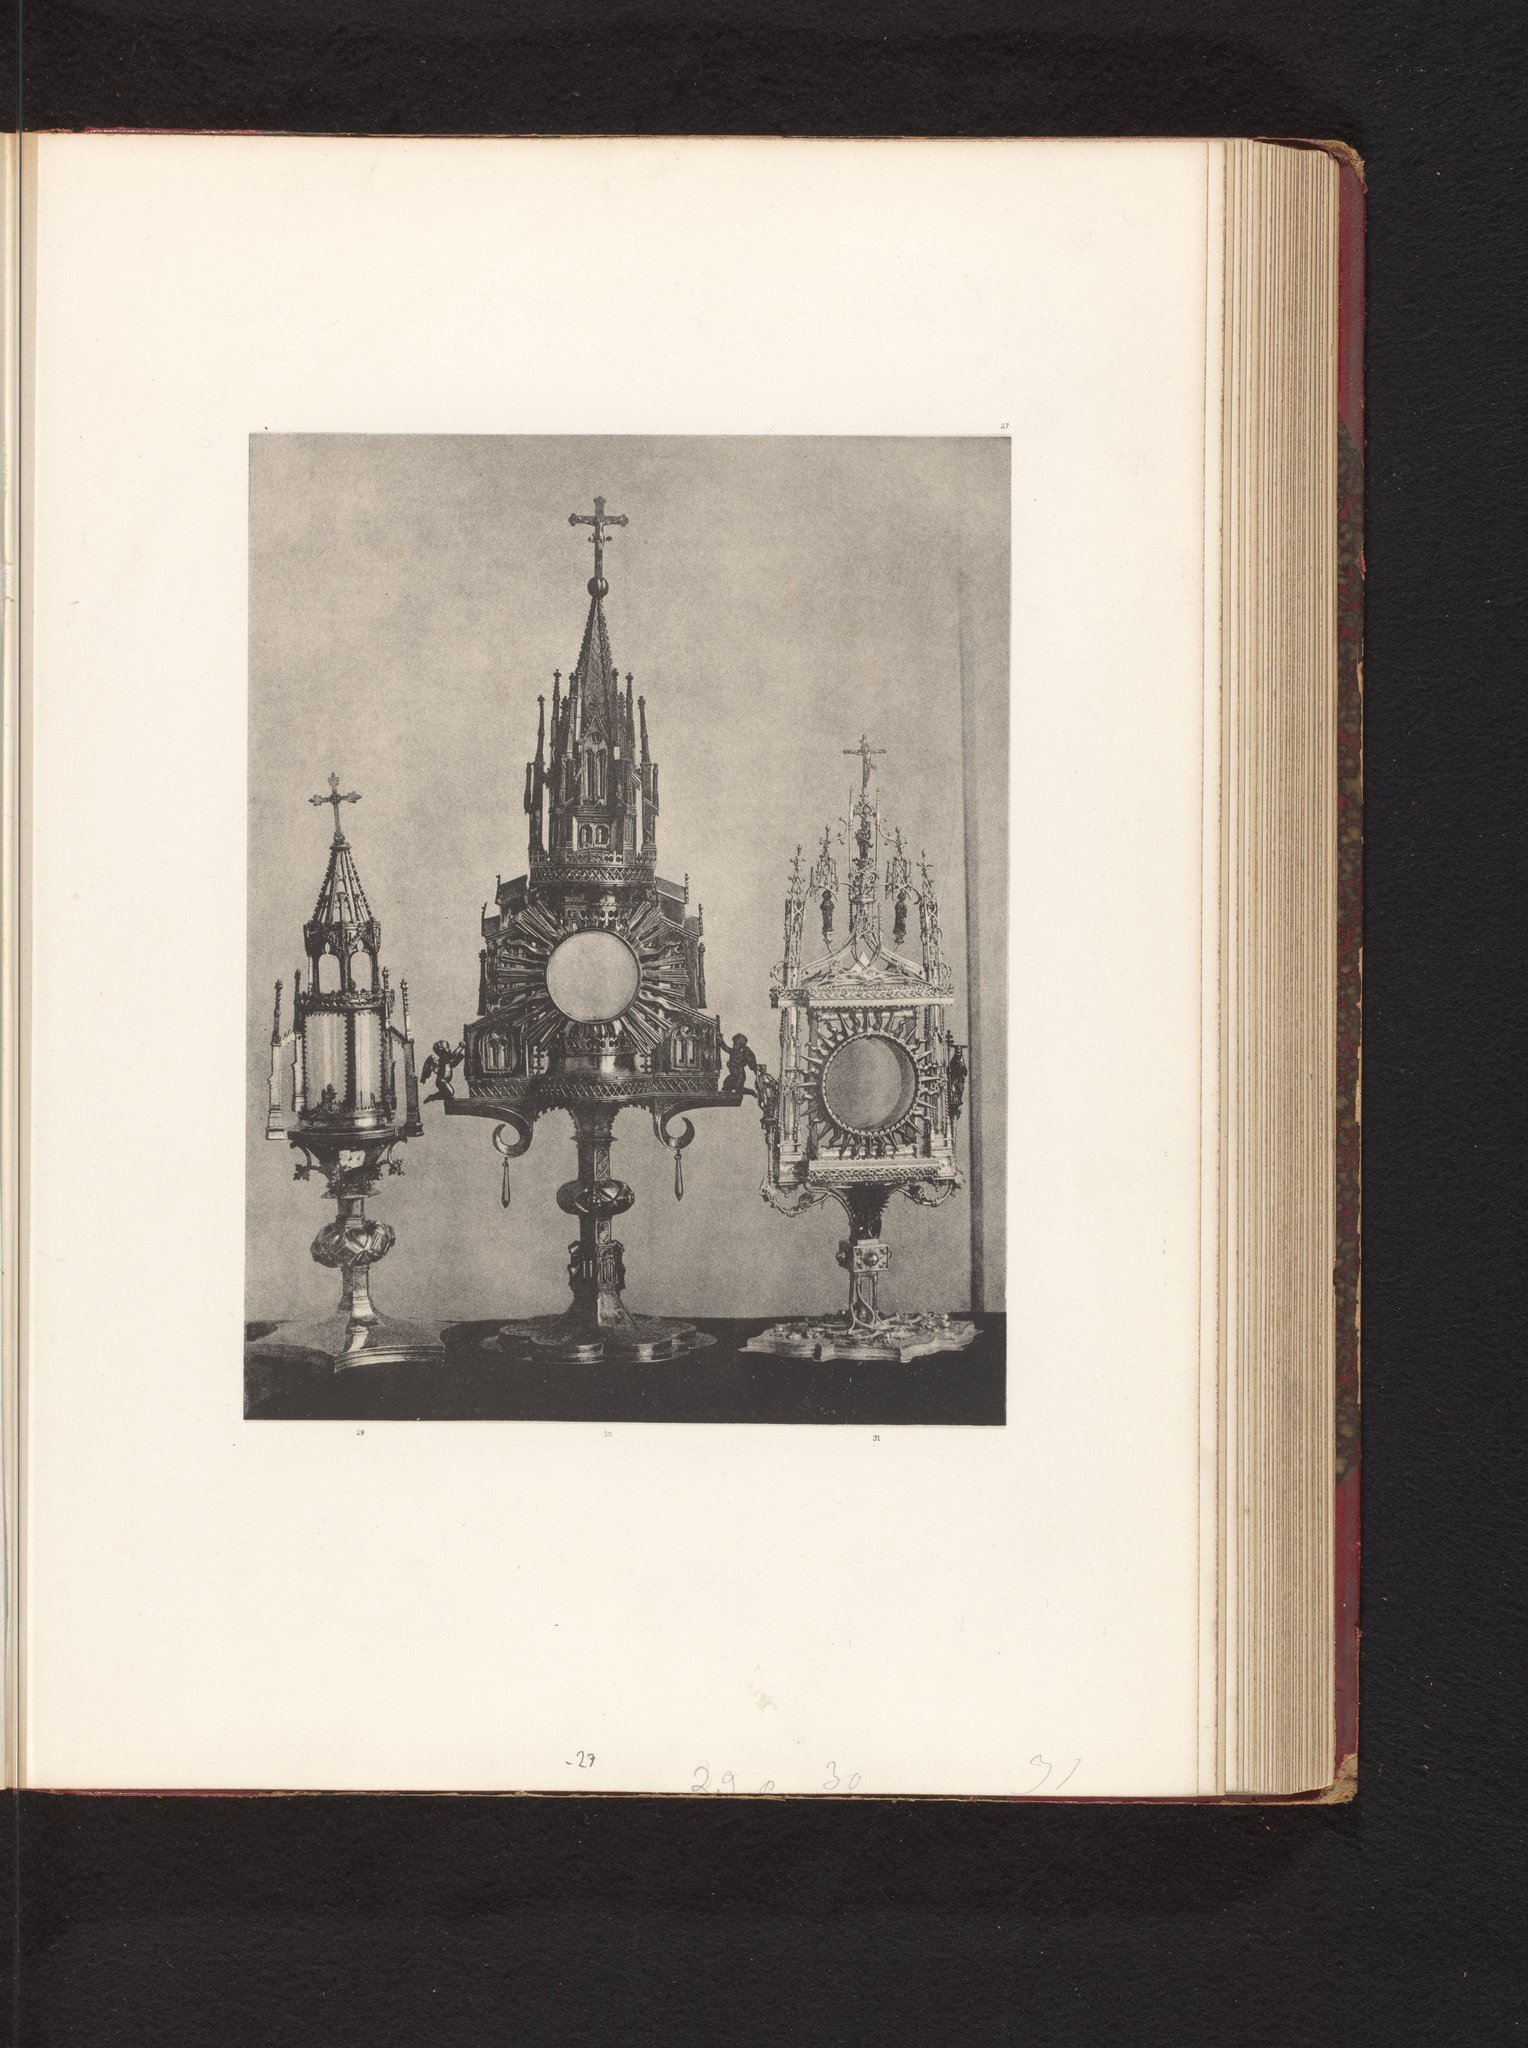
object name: page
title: Drie vergulde monstransen, opgesteld op een tentoonstelling over religieuze objecten uit de middeleeuwen en renaissance in 1864 in Mechelen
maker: joseph maes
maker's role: fotograaf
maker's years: 1838-1908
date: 1864-1866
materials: paper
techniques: photolithography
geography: mechelen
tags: ostensorium, monstrance, mechelen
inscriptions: number: ‘-27’, number: ‘29. 30. 31’, number: ‘29 - 30 - 31’